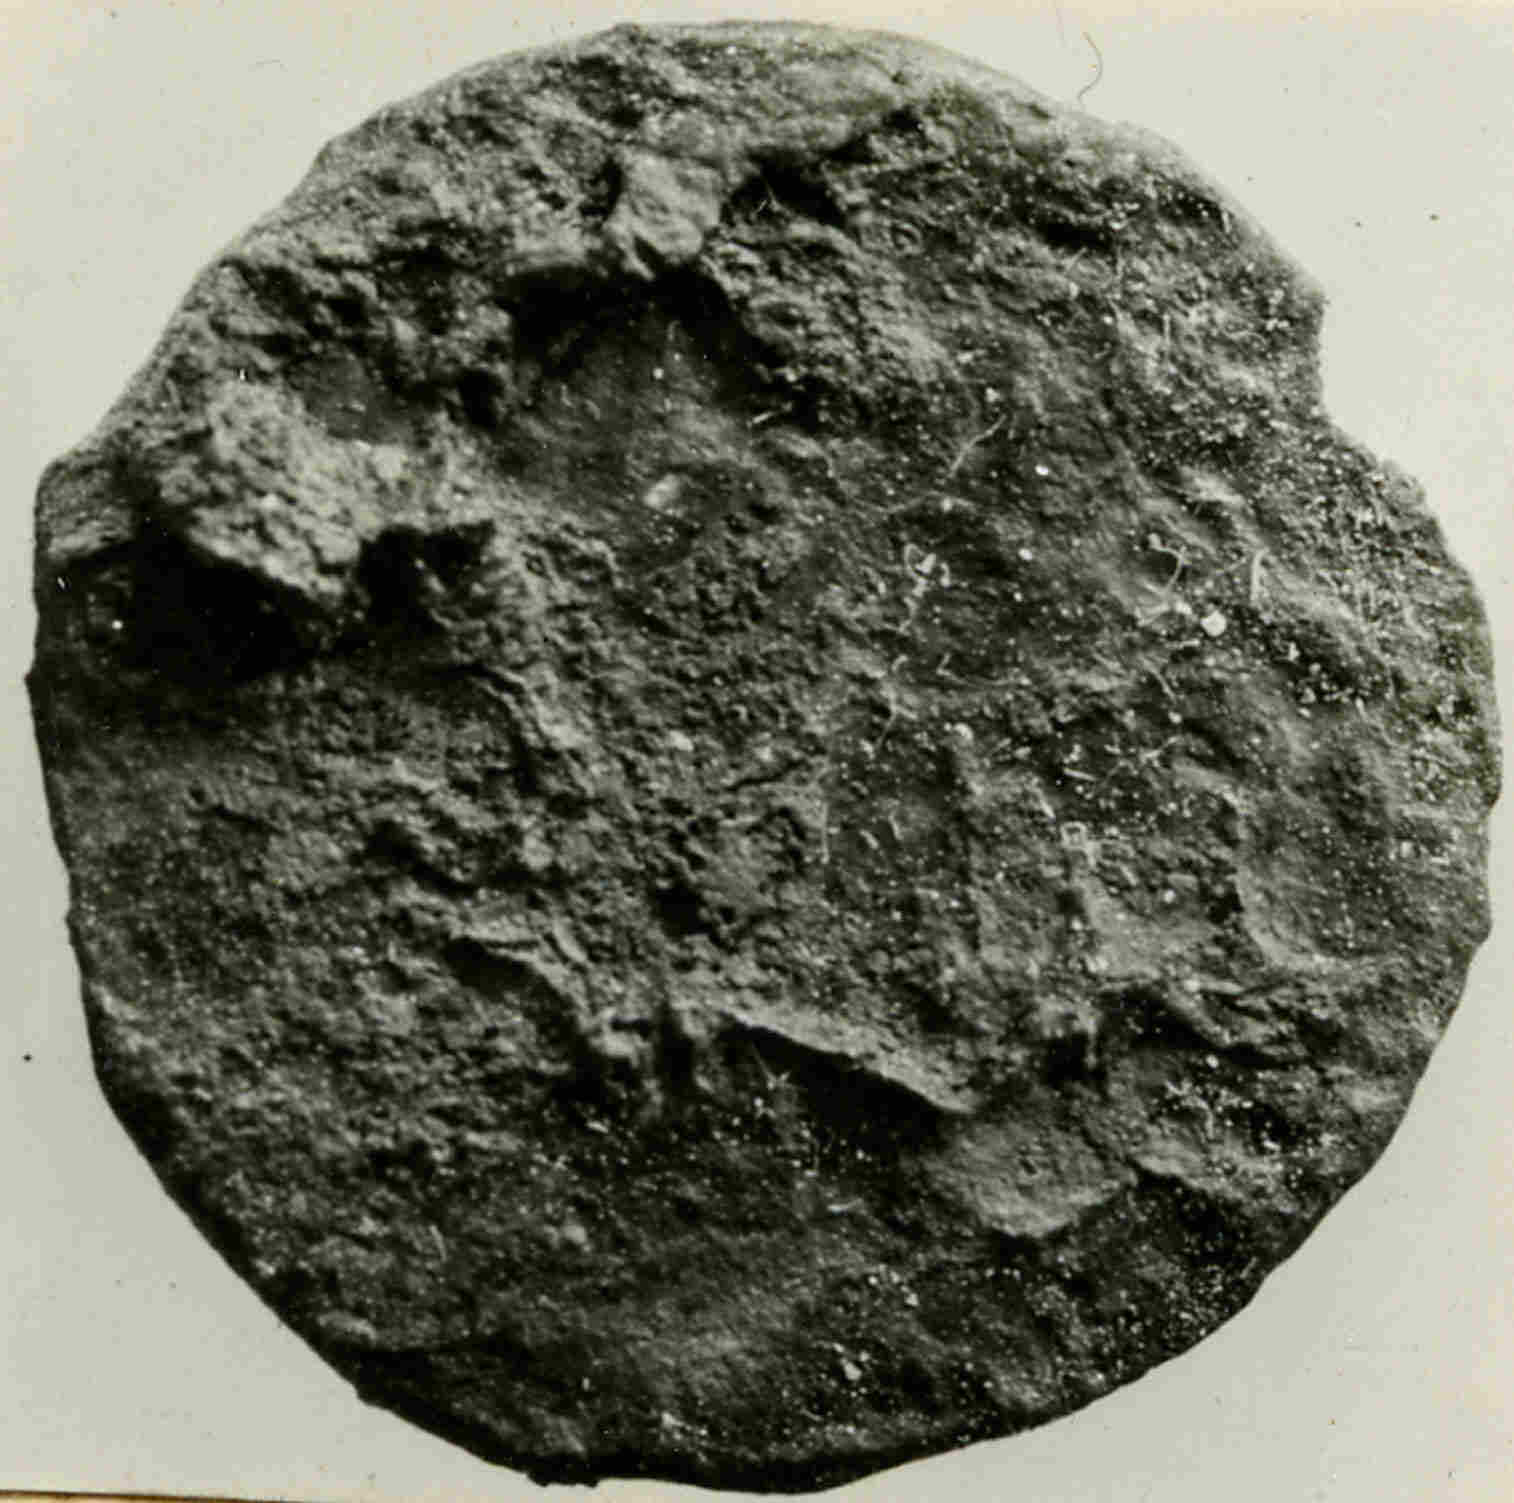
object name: coin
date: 701-900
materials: copper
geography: iran